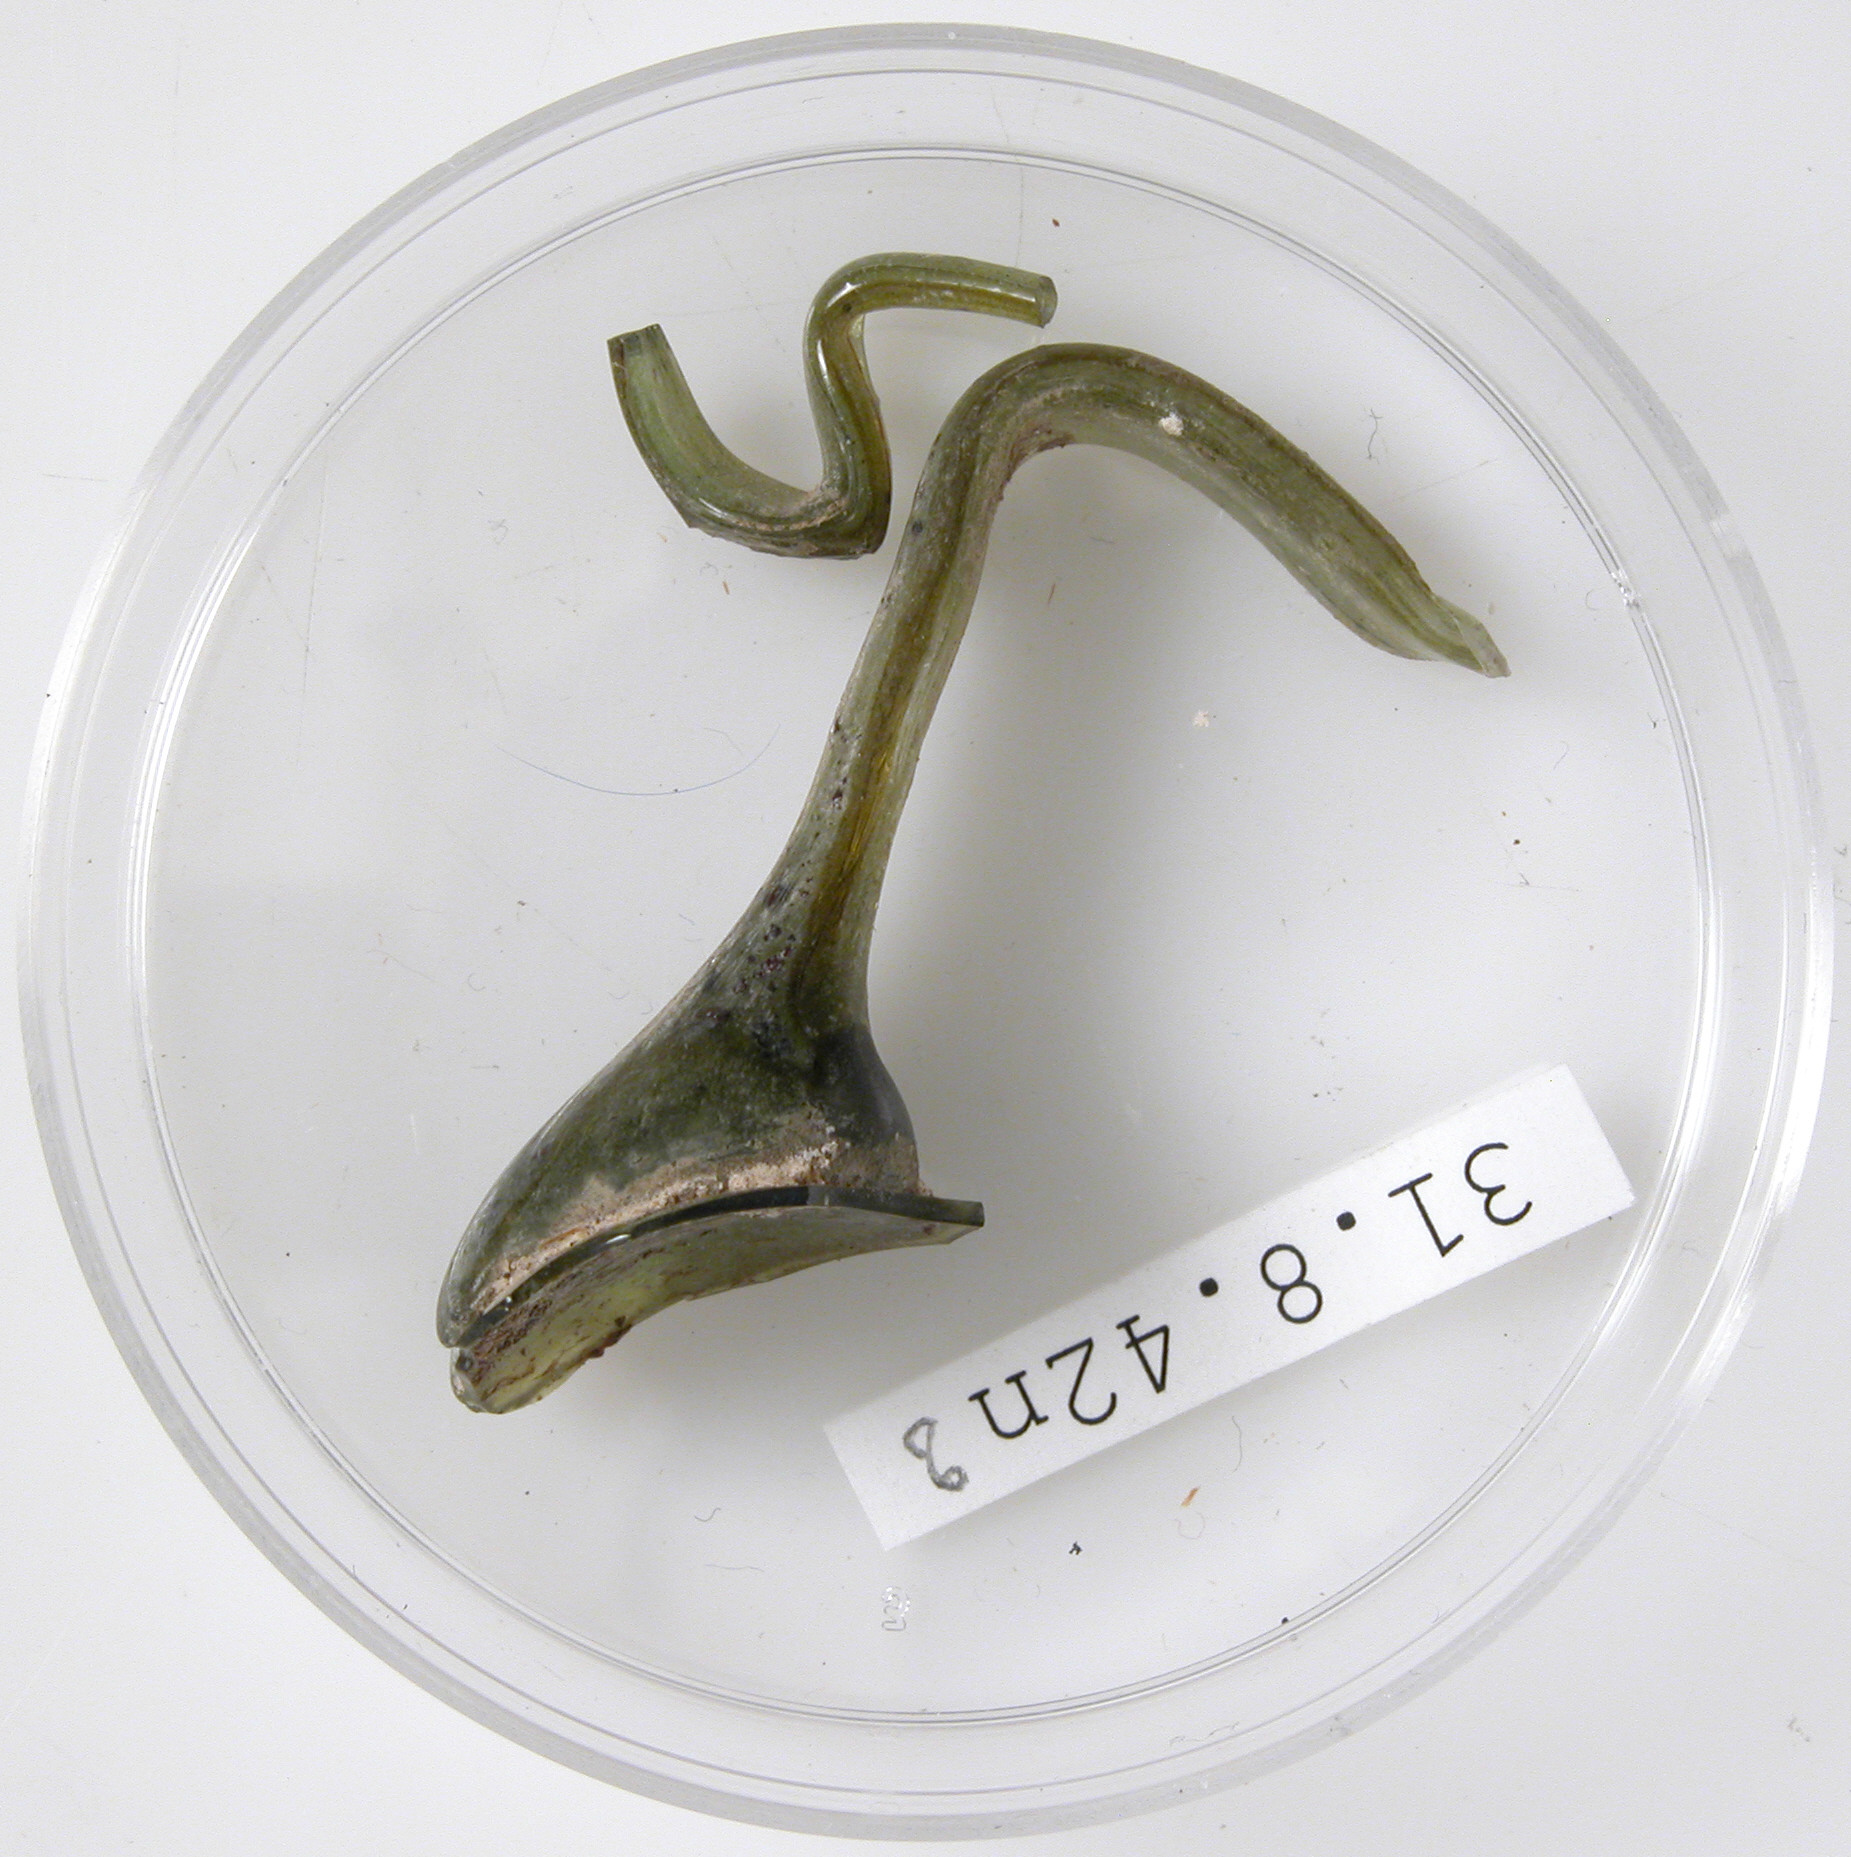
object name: fragment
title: Glass Fragments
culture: coptic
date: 301-400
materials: glass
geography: egypt